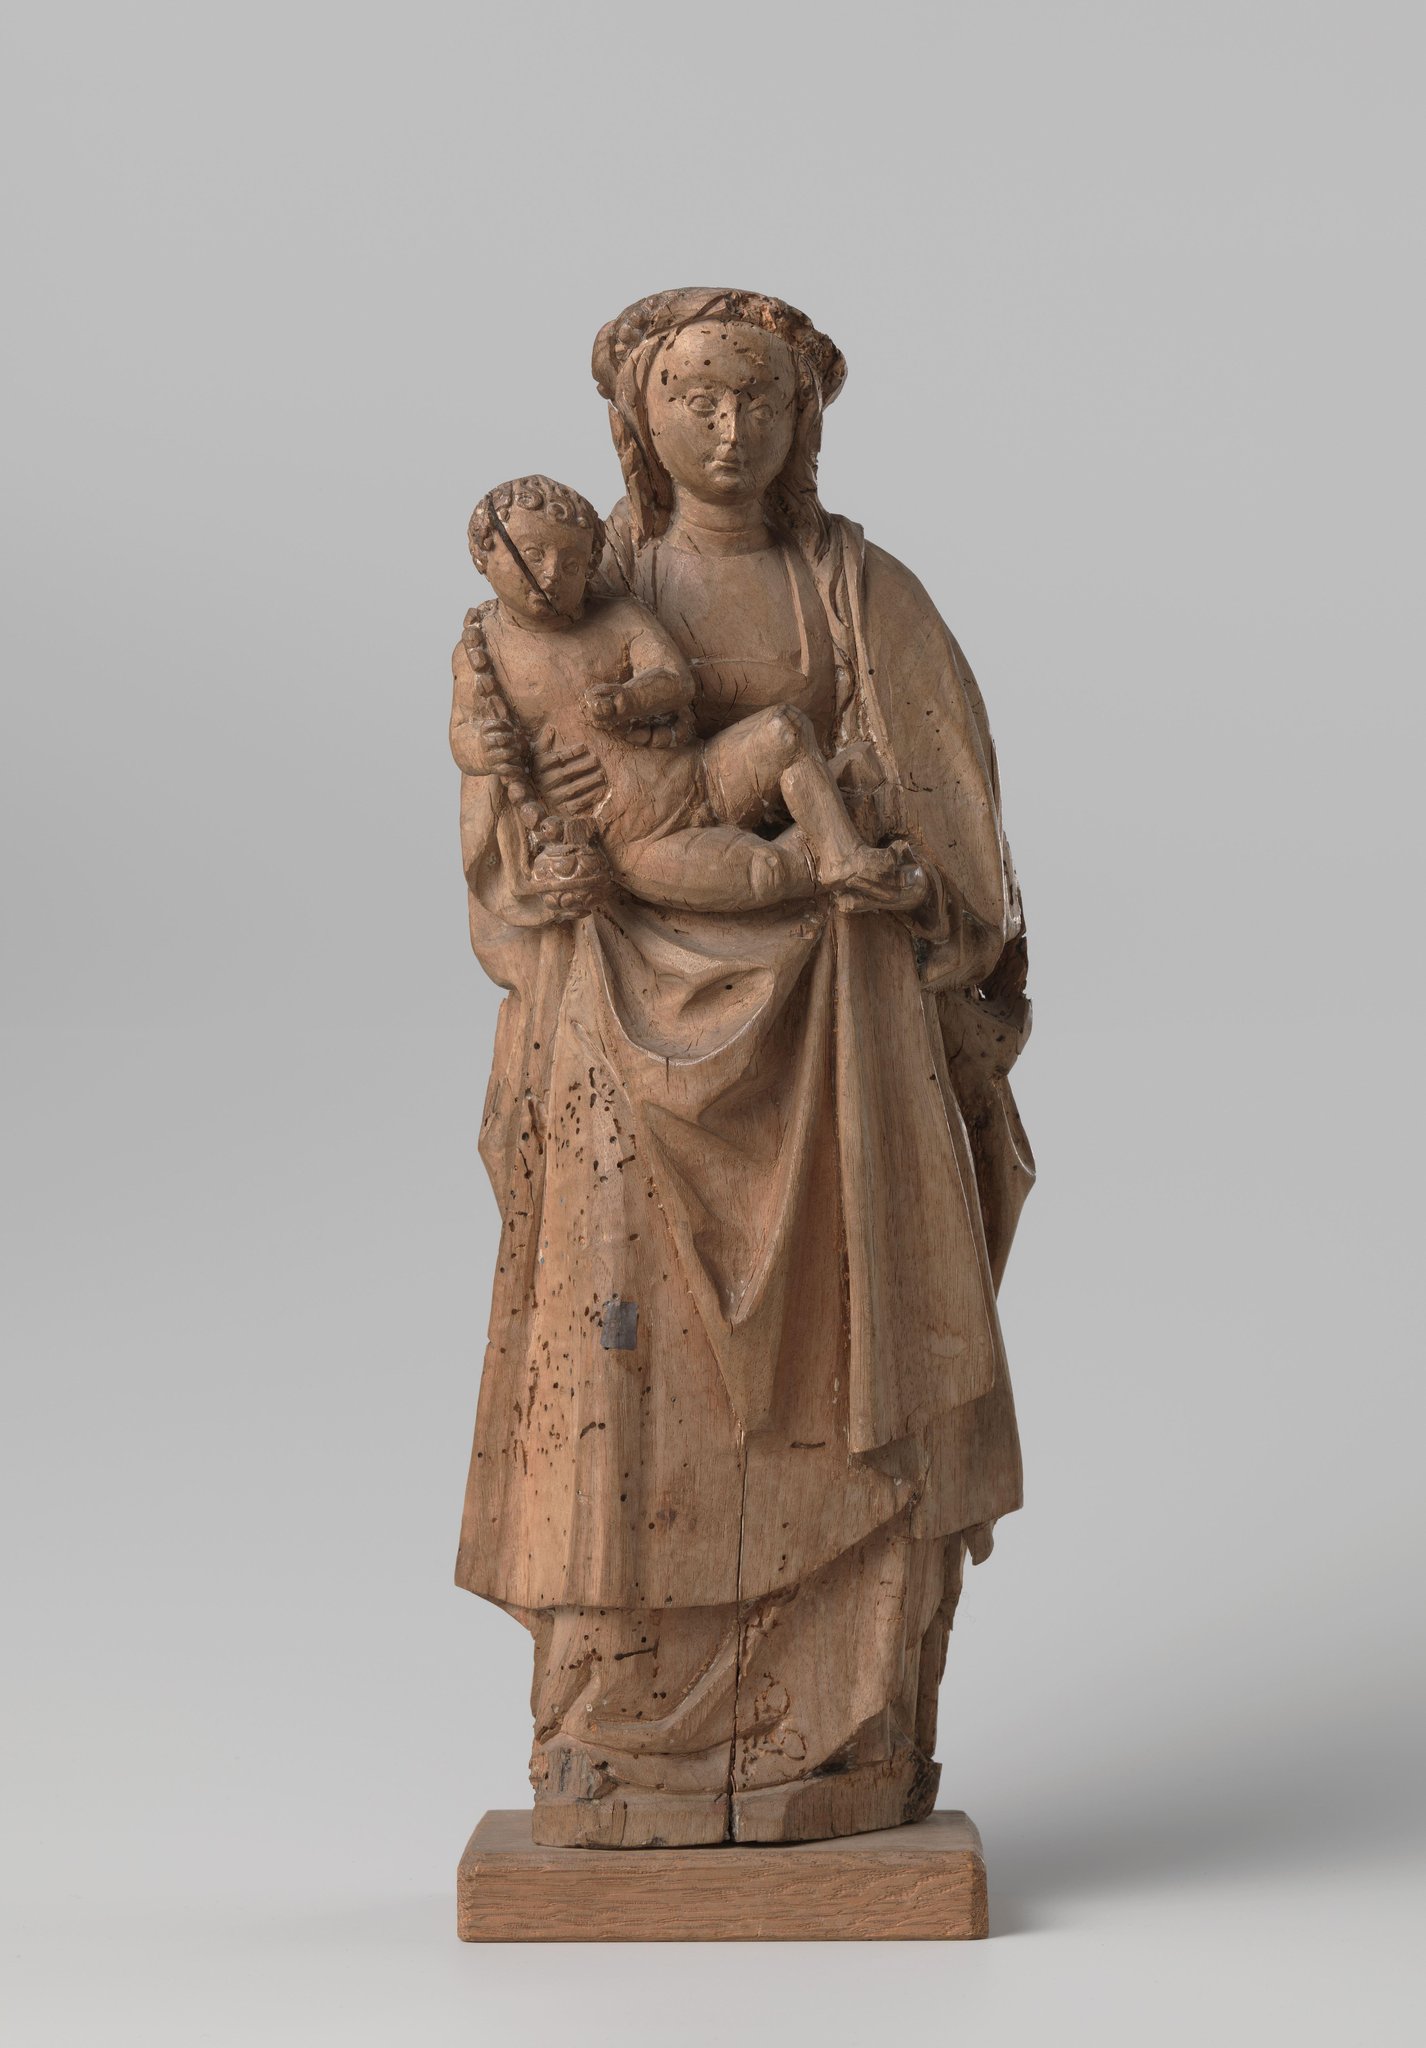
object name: sculpture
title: Virgin and Child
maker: Anonymous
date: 1515-1520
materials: wood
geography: mechelen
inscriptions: mark, on the reverse, branded: three vertical pales (the Mechelen wood quality mark)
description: Zij staat op een plintvormig grondje met het rechterbeen naar voren, houdt met de rechterhand het naakte, naar de beschouwer toegewende kind, van wie zij met de linker de gekruiste beentjes vast heeft. Het Kind houdt met beide handen een om hem heen hangende rozenkrans, waaraan een gebedsnoot hangt. Om het hoofd draagt Maria een gewonden parelband, over het onderkleed een gewaad met mouwen en lage rechthoekige halsuitsnijding. De mantel, die naar rechts is toegeslagen, wordt onder beide armen opgehouden.